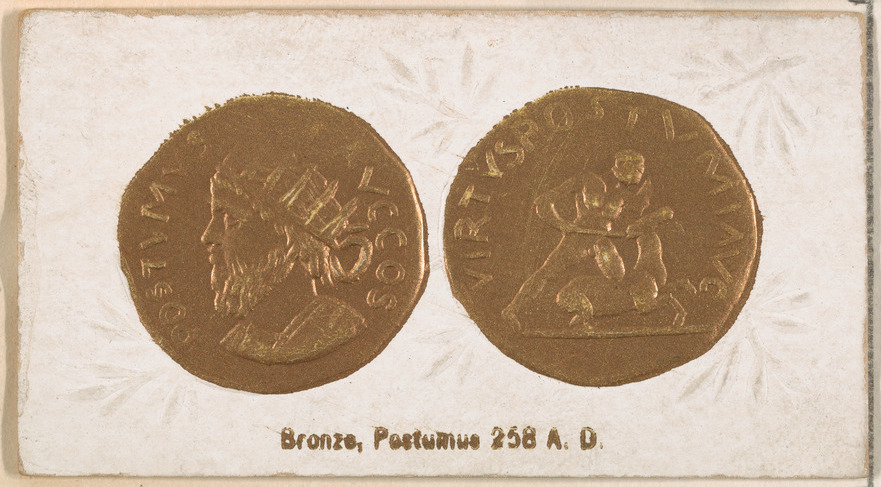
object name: print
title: Bronze, Postumus, 258 A.D., from the Ancient Coins series (N180) issued by Wm. S. Kimball & Co.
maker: william s. kimball & company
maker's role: publisher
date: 1888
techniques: color lithograph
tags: men,coins